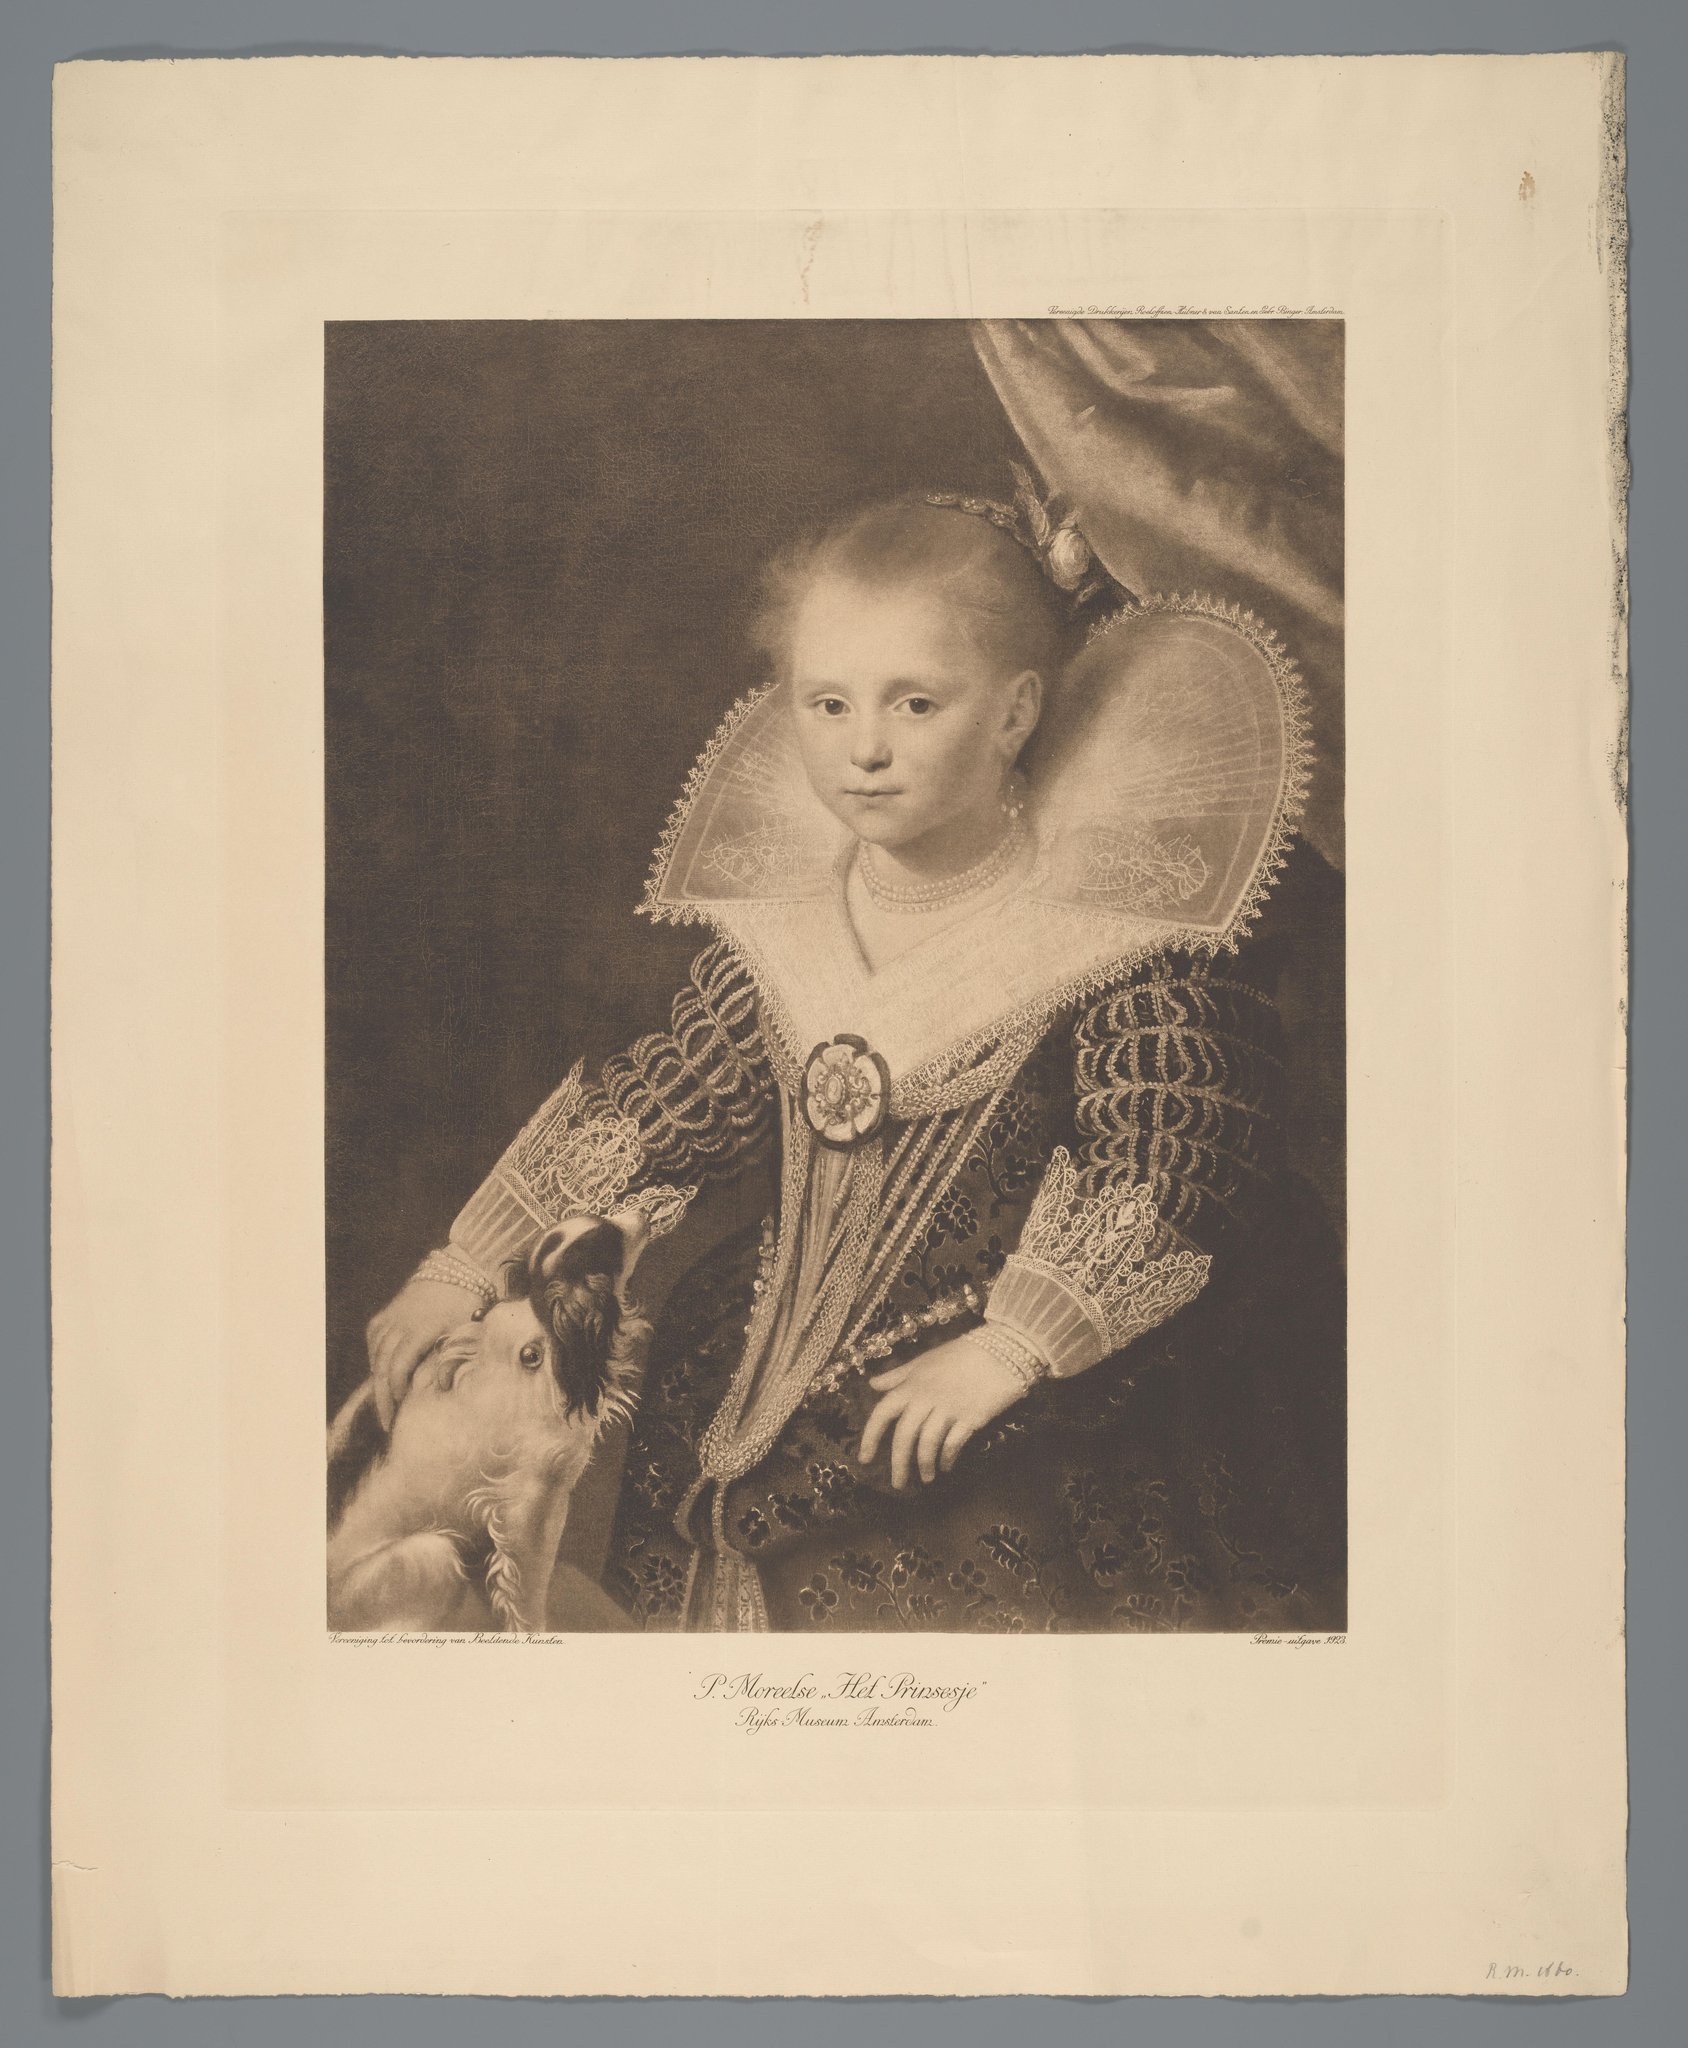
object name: photomechanical print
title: P. Moreelse "Het Prinsesje"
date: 1919-1924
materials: paper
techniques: photoaquatint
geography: amsterdam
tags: historical persons not known by name - bb - woman, girl (child between toddler and youth), contemplating nature, picture, painting